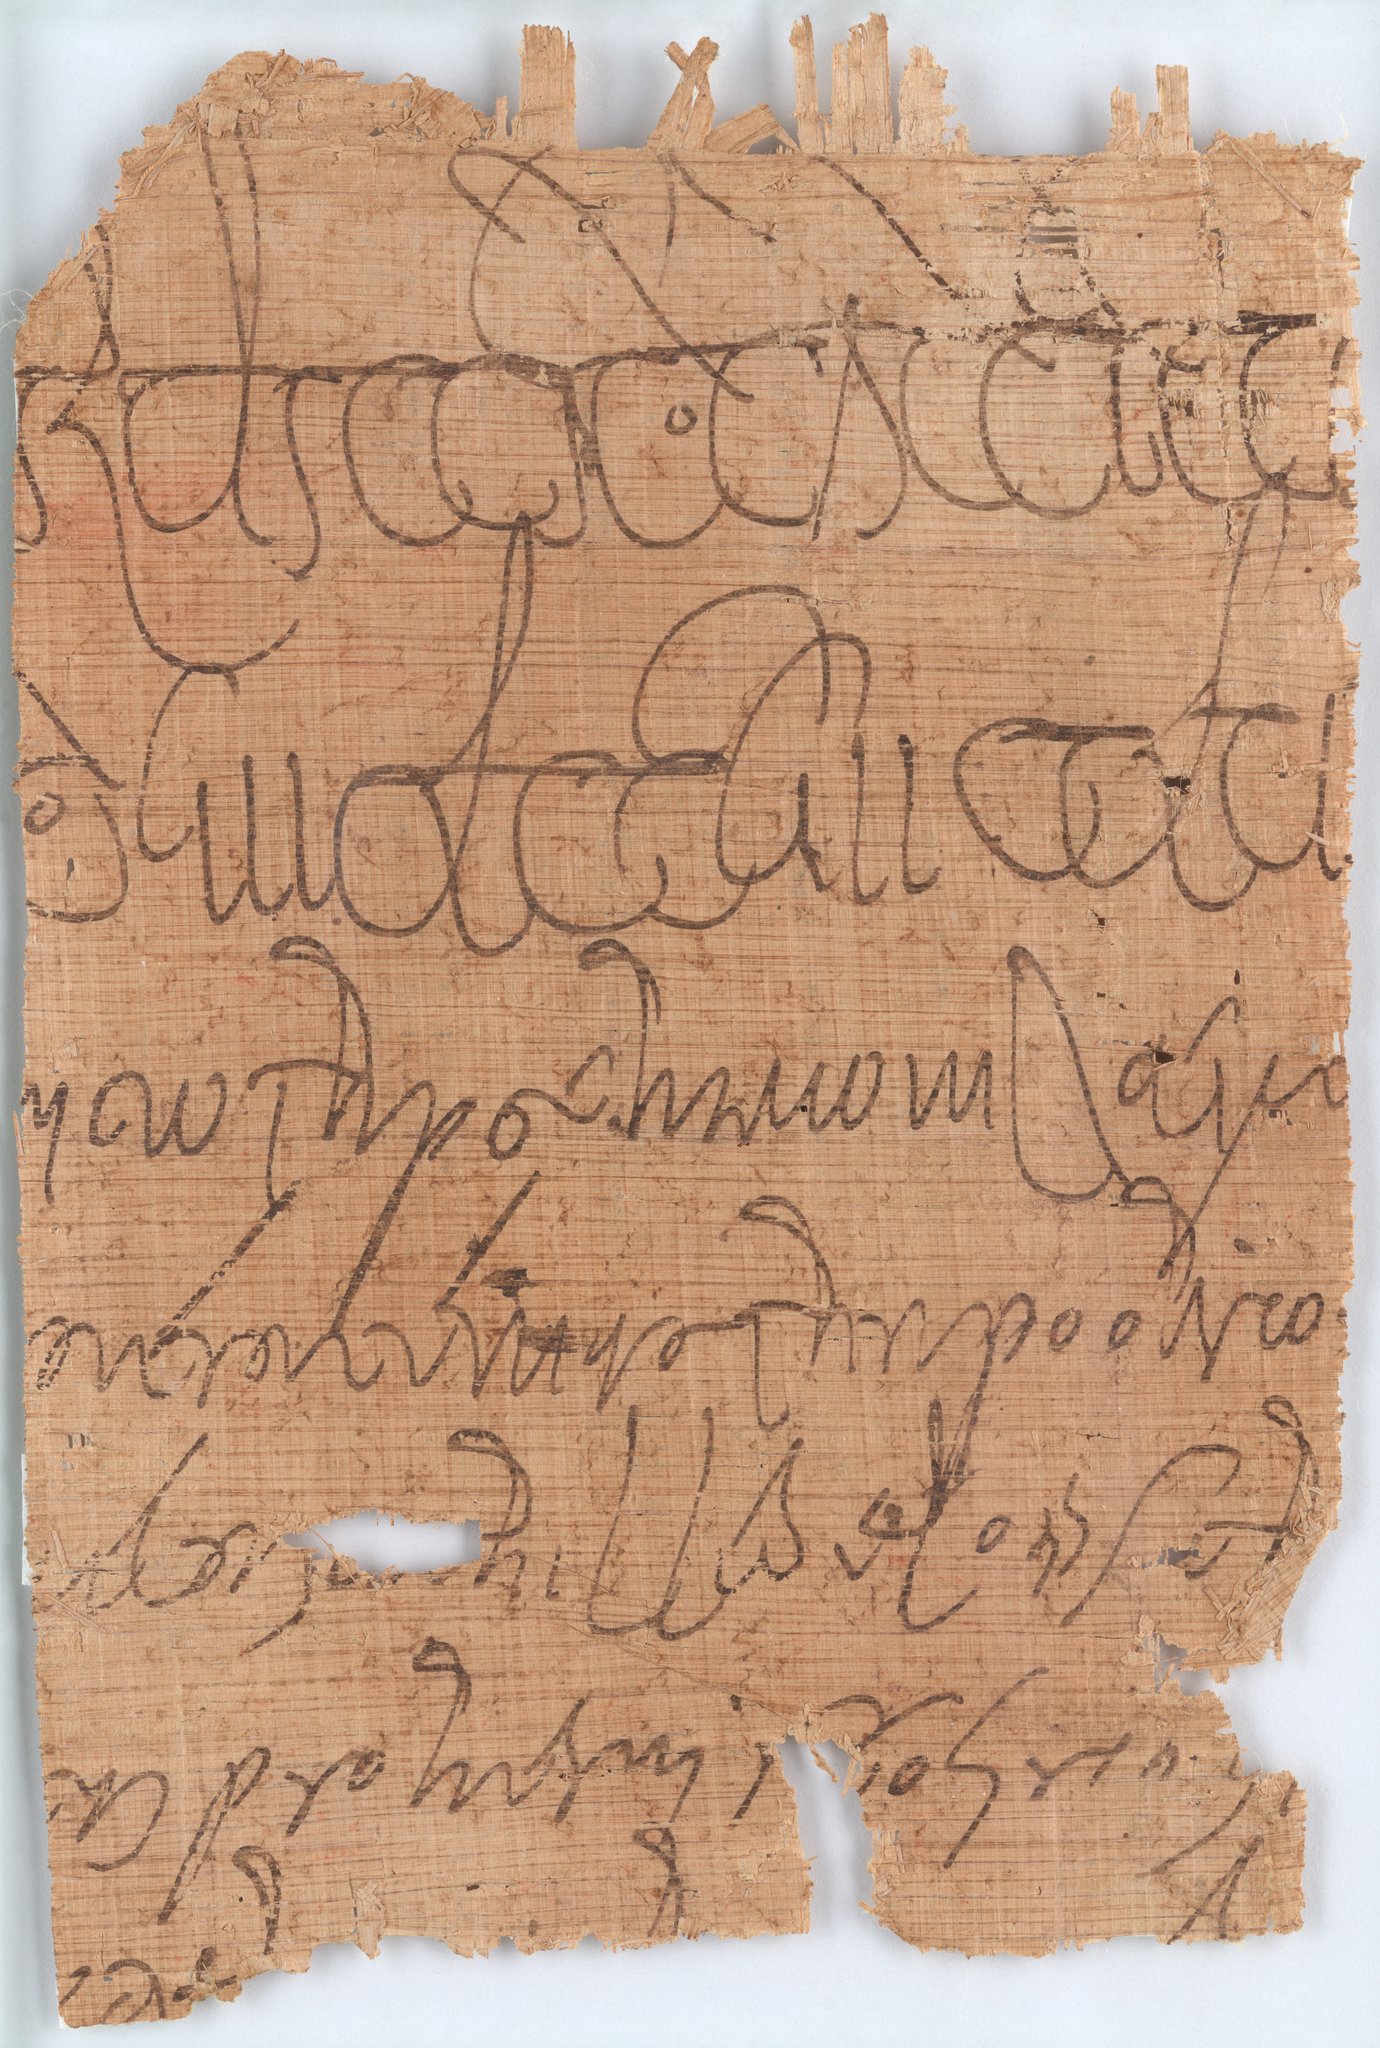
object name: fragment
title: Papyrus fragment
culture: egyptian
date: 400 BCE-600 CE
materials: ink, papyrus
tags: greek